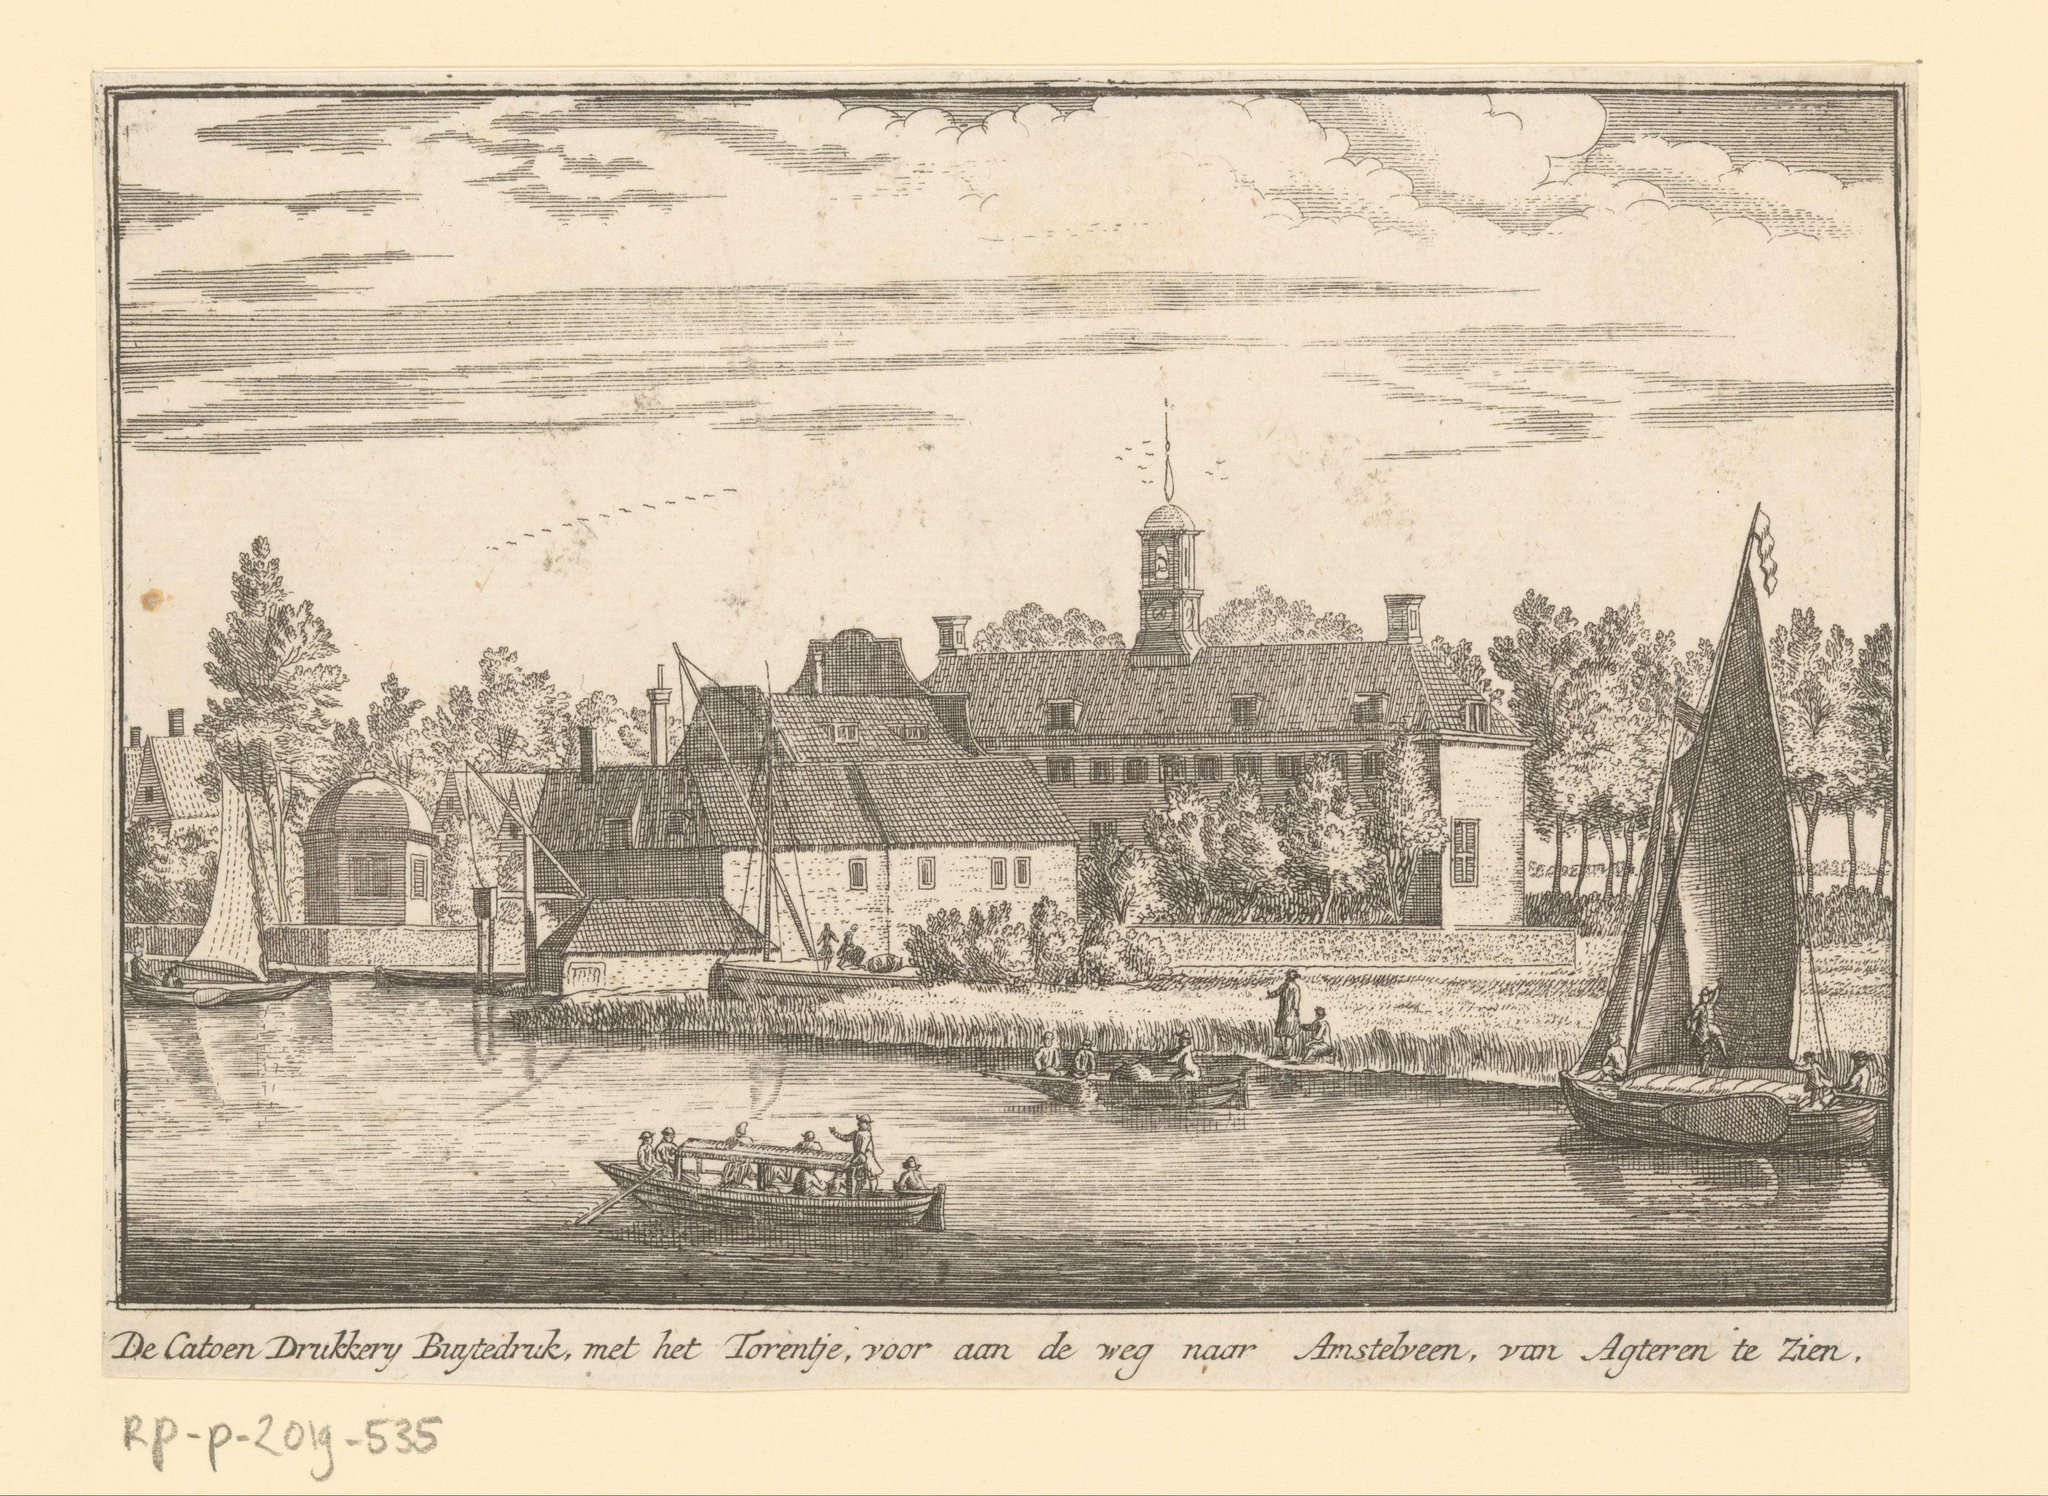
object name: print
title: De Catoen Drukkery Buytedruk, met het Torentje, voor aan de weg naar Amstelveen, van Agteren te zien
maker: abraham rademaker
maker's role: draughtsman, print maker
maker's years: 1676-1735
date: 1730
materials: paper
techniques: etching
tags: cotton (material ~ textile industry), canals, waters (in city)